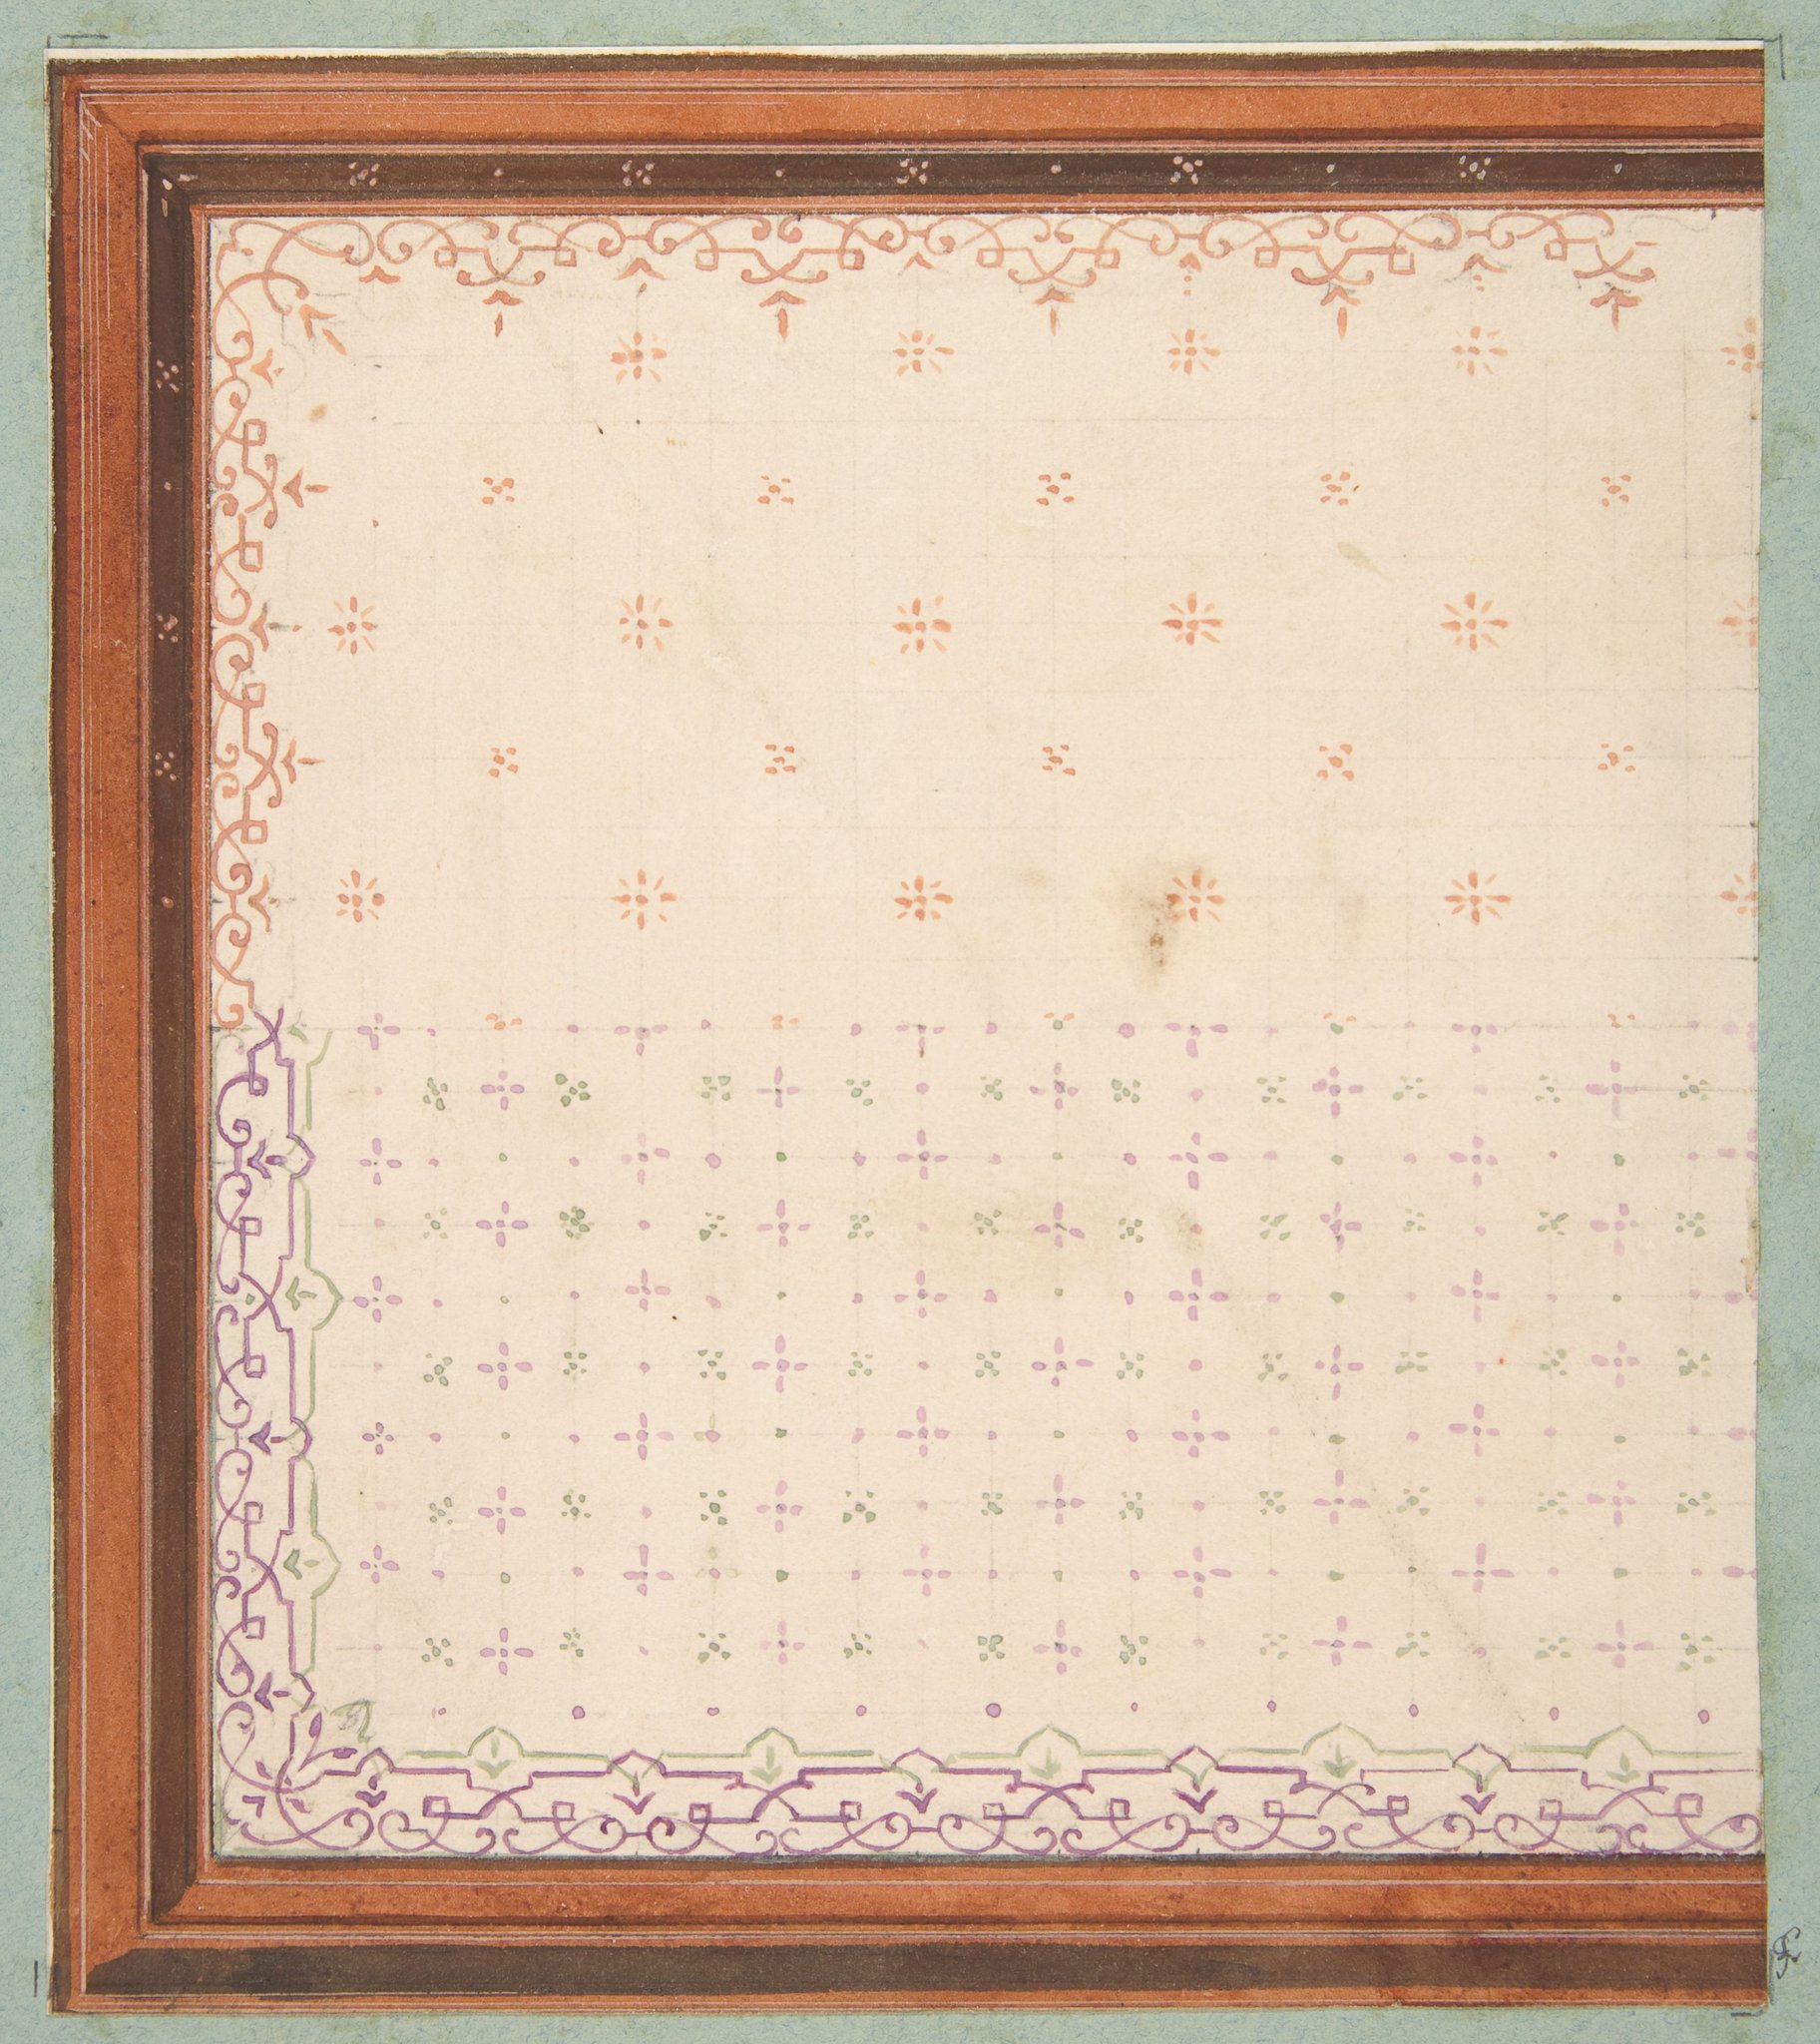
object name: drawing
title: Design for a ceiling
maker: jules-edmond-charles lachaise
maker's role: artist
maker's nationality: french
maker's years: 1897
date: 1851-1900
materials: graphite, ink, watercolor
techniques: pen